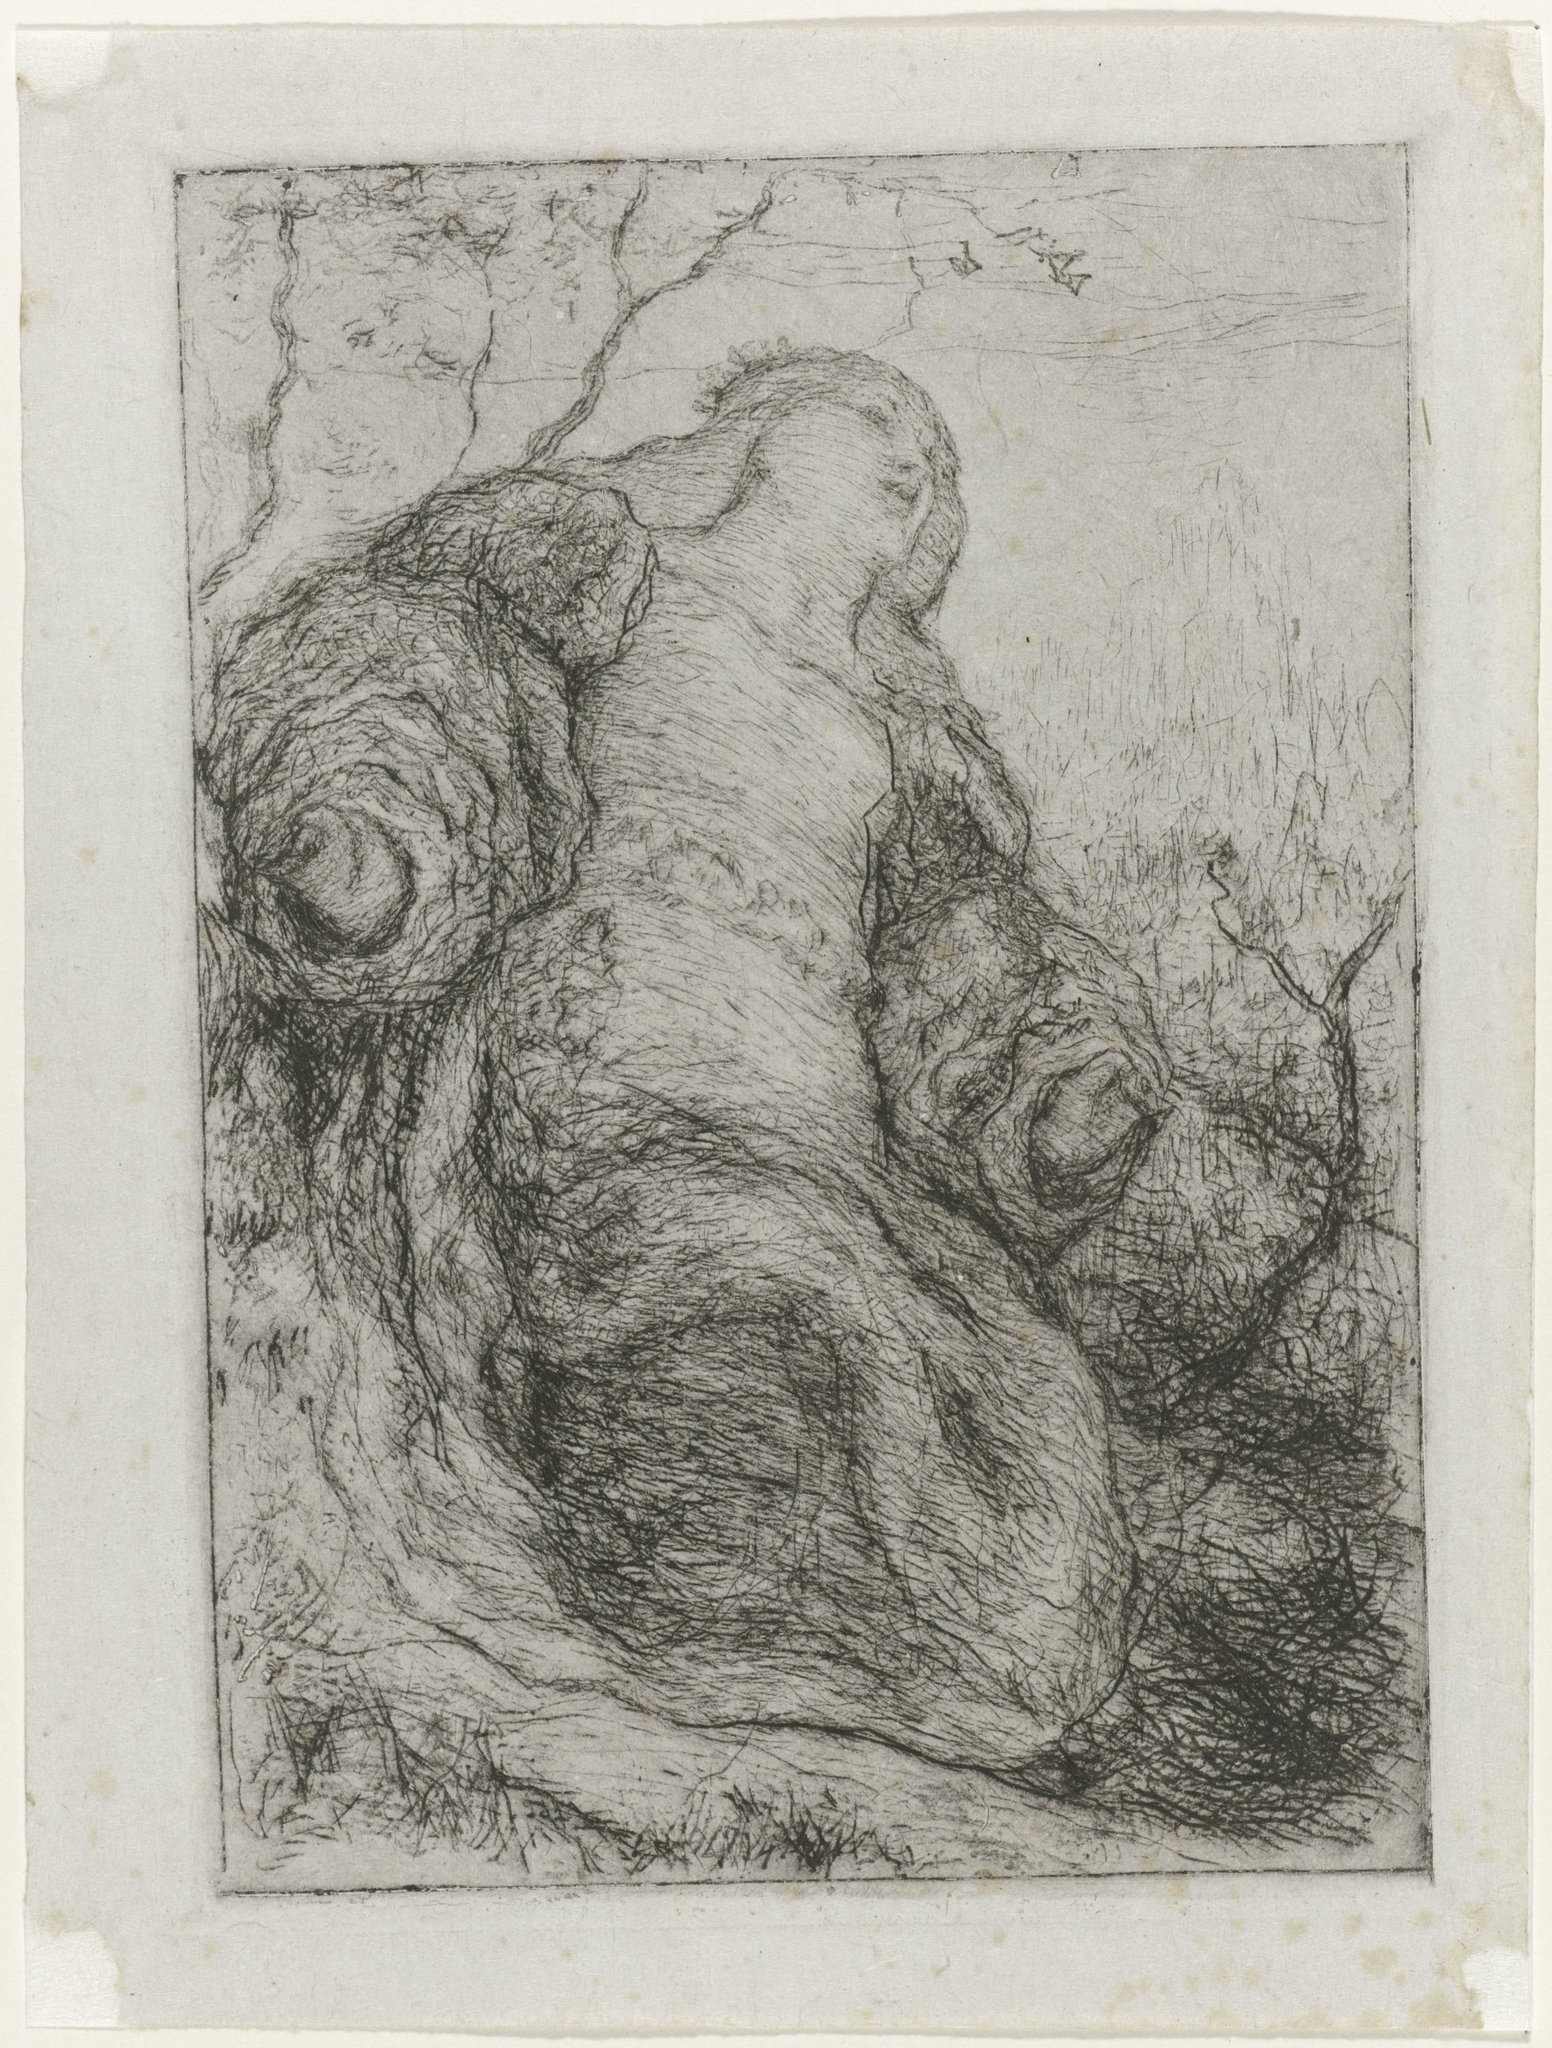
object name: print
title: Vrouw onder een boom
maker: matthijs maris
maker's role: draughtsman, painter, print maker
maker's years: 1839-1917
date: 1887-1888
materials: paper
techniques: etching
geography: london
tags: womanhood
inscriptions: collector's mark: Lugt 2228, collector's mark: Lugt 2760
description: De 'Lady of Shalott' zittend onder een boom, schuin van onderen gezien, naar rechts.